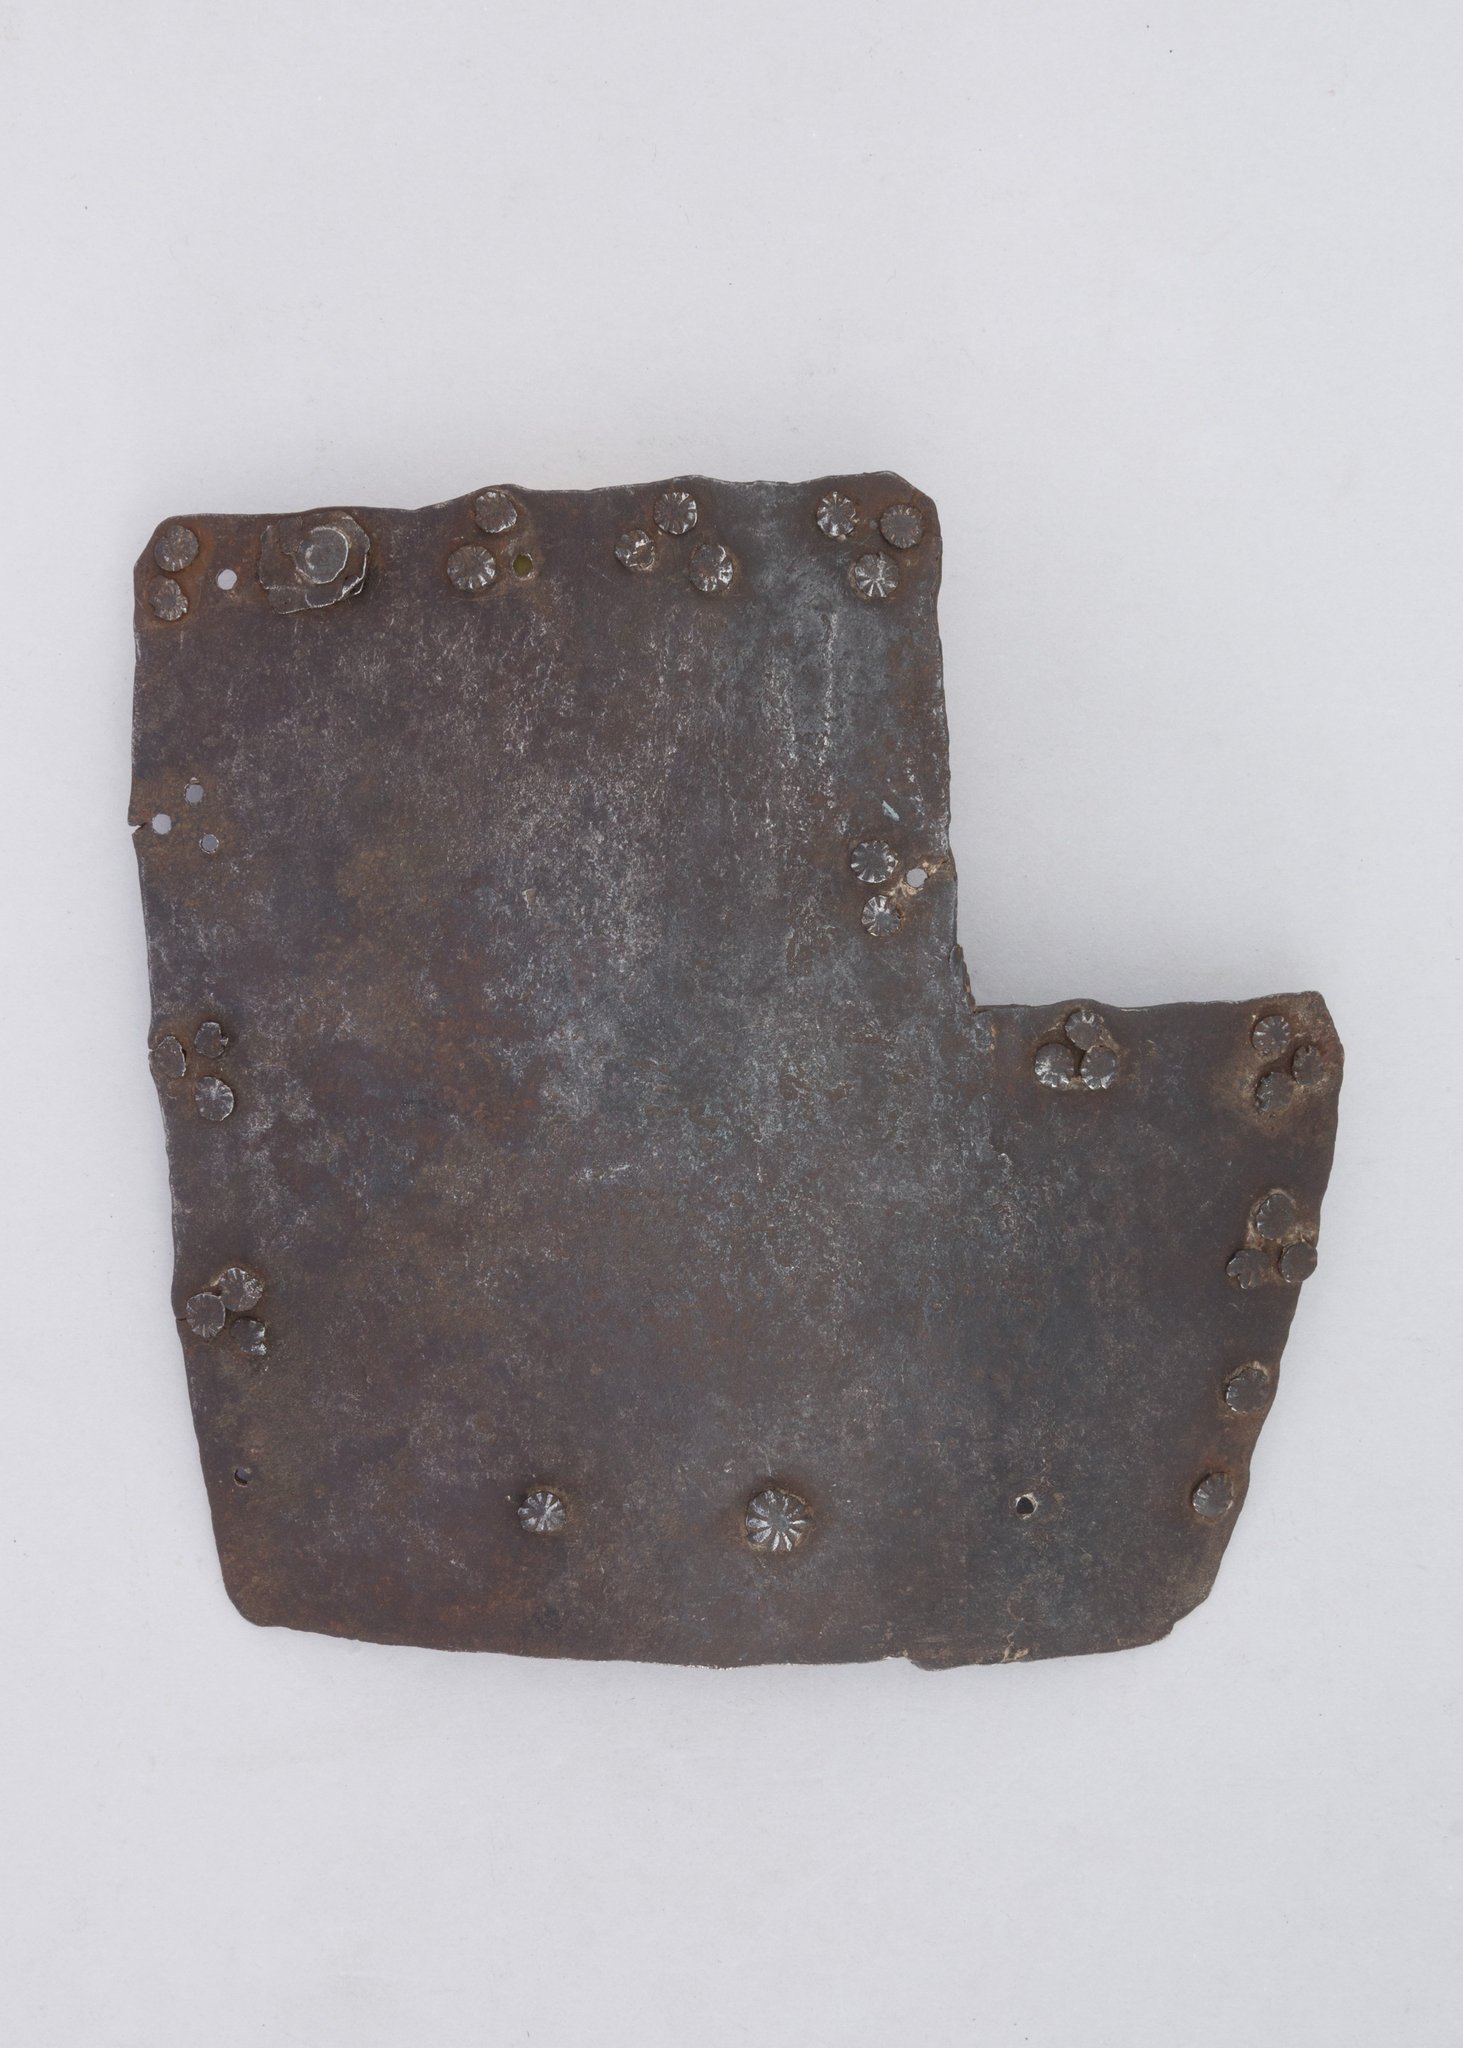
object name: brigandine plate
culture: italian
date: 1400-1450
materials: metal alloy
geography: italy